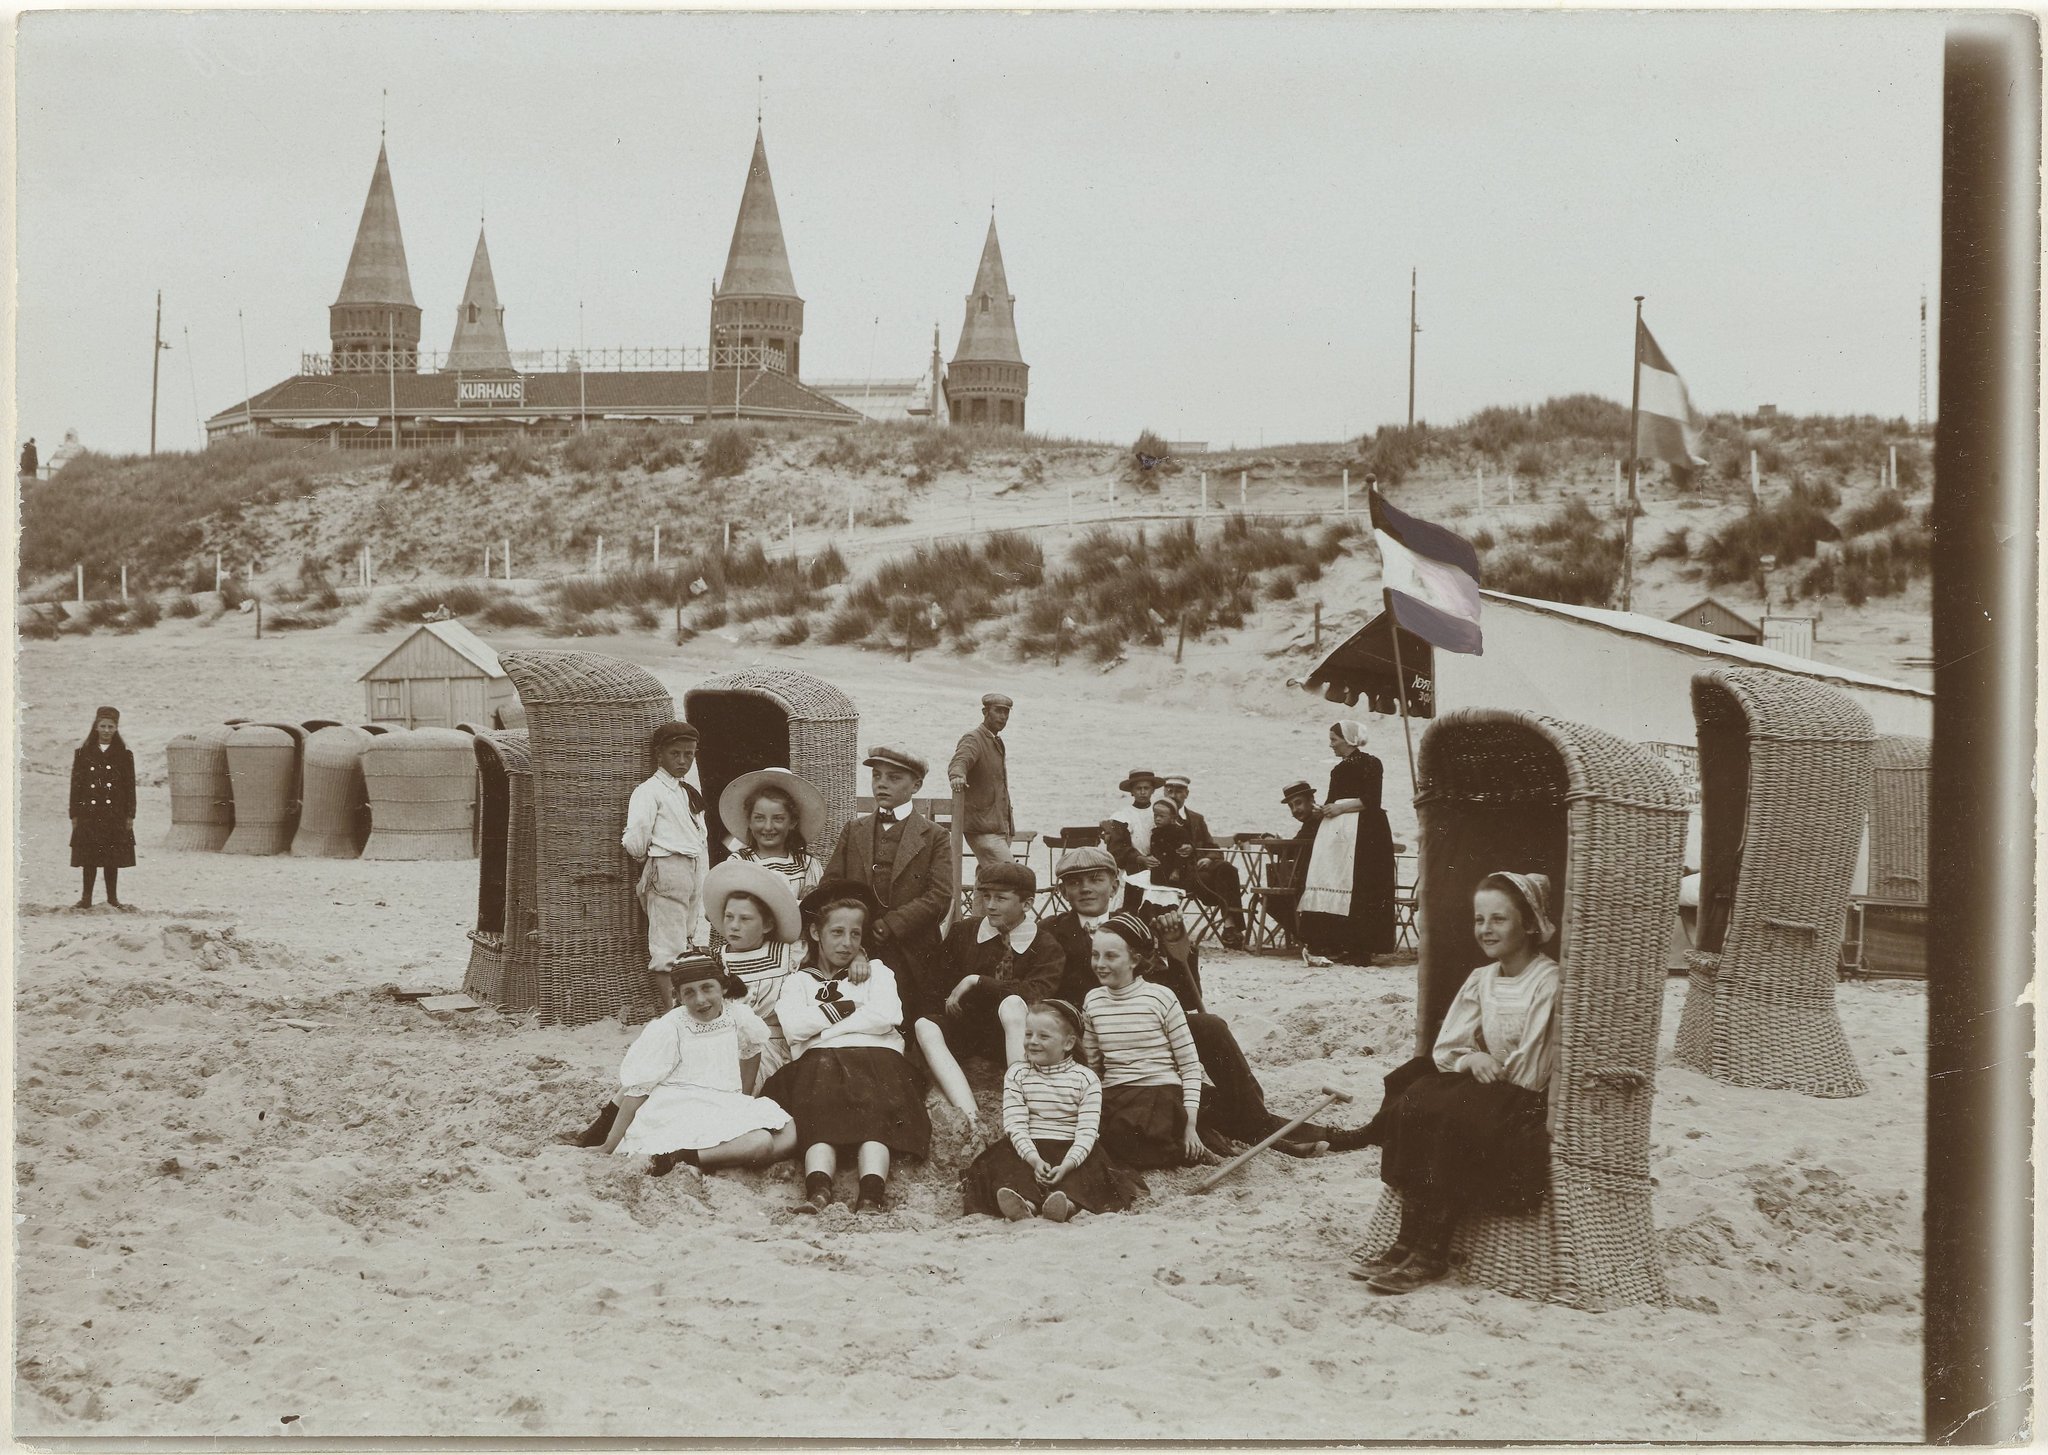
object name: photograph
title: Kinderen aan het strand in Zandvoort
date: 1900-1905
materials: photographic support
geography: zandvoort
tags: beach (as place of recreation)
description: Strand van Zandvoort gezien vanaf de zee. Op de achtergrond het Kurhaus. Op de voorgrond zit een groep kinderen in rieten strandstoelen.